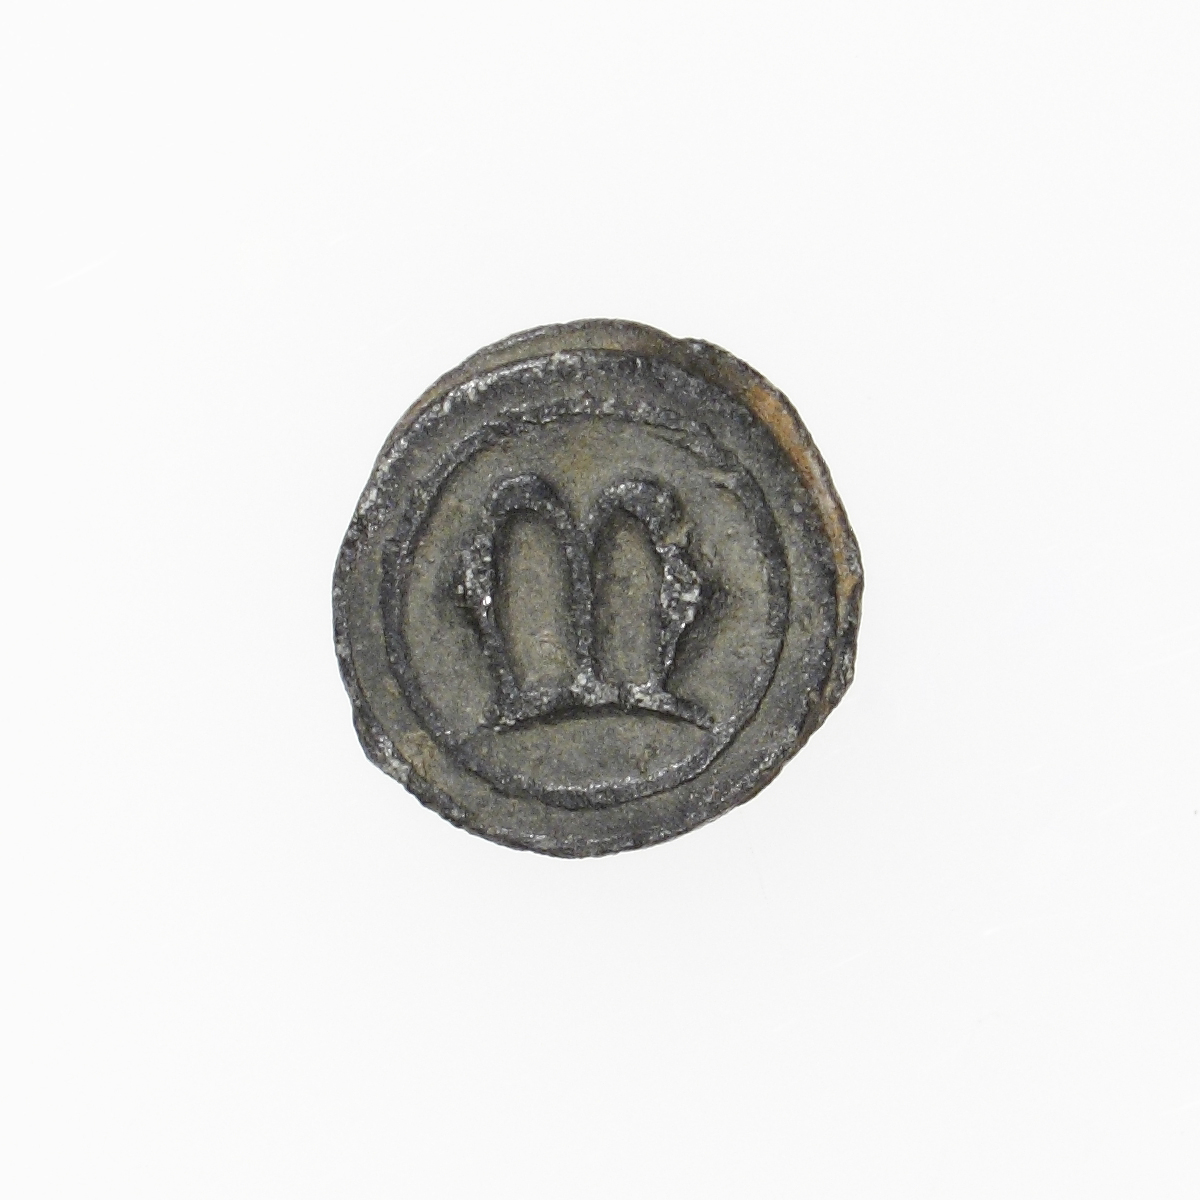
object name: pilgrim's badge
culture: french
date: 1301-1600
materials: lead